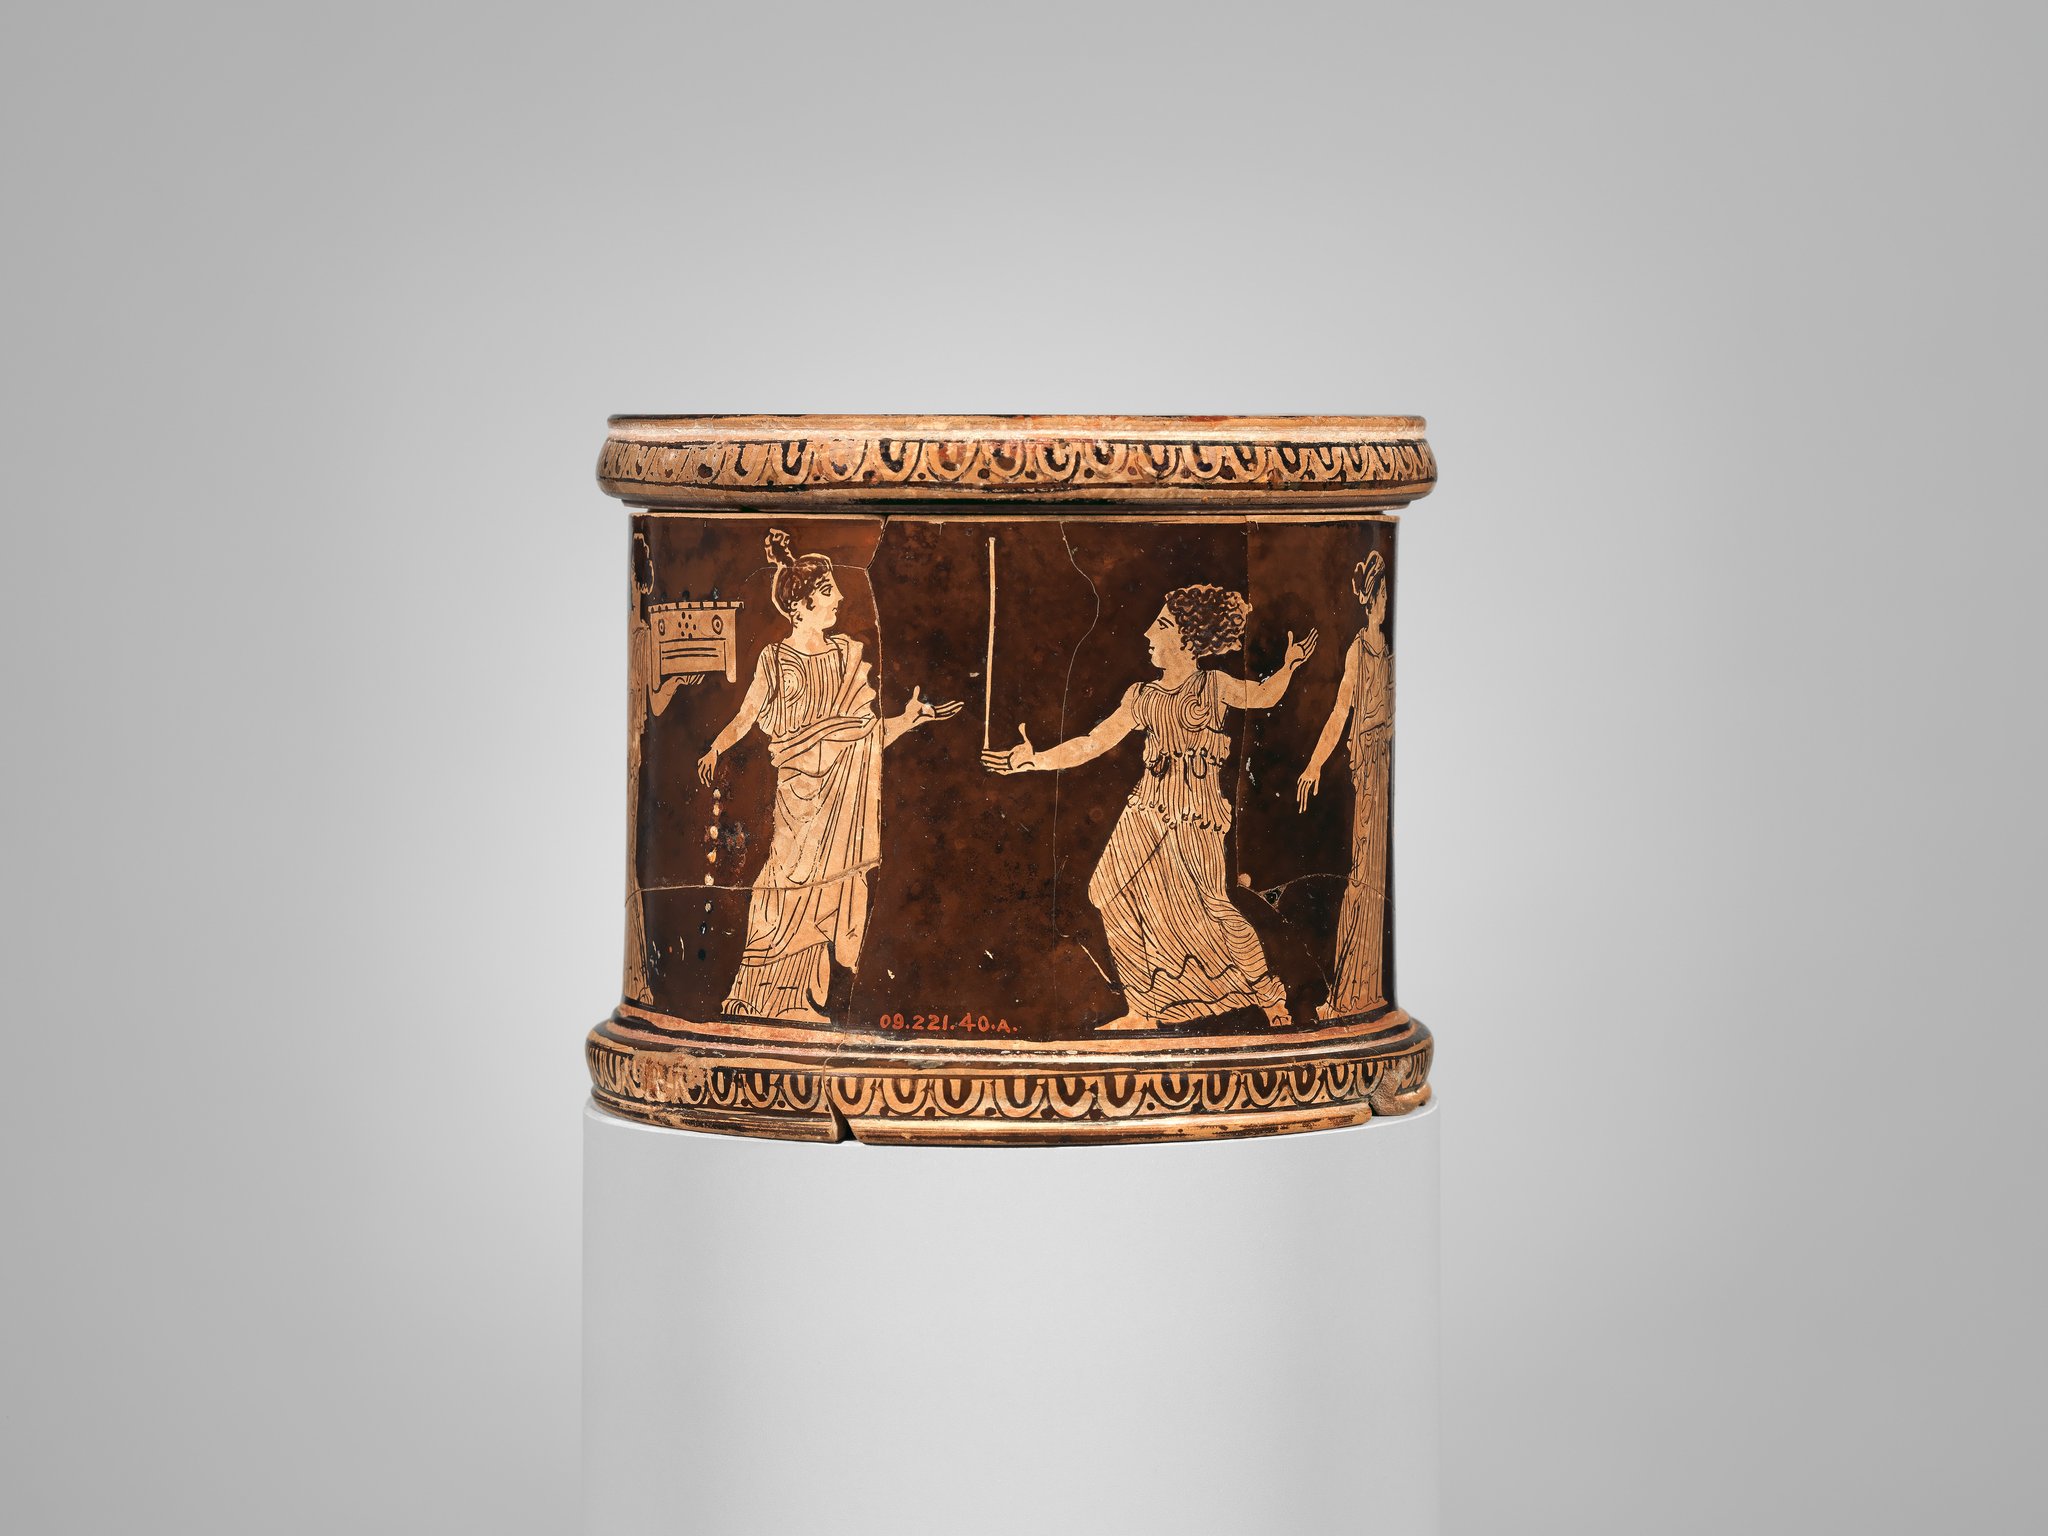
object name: pyxis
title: Terracotta pyxis (box)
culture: greek, attic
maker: meidias painter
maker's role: artist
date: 420-410 BCE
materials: terracotta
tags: women,aphrodite